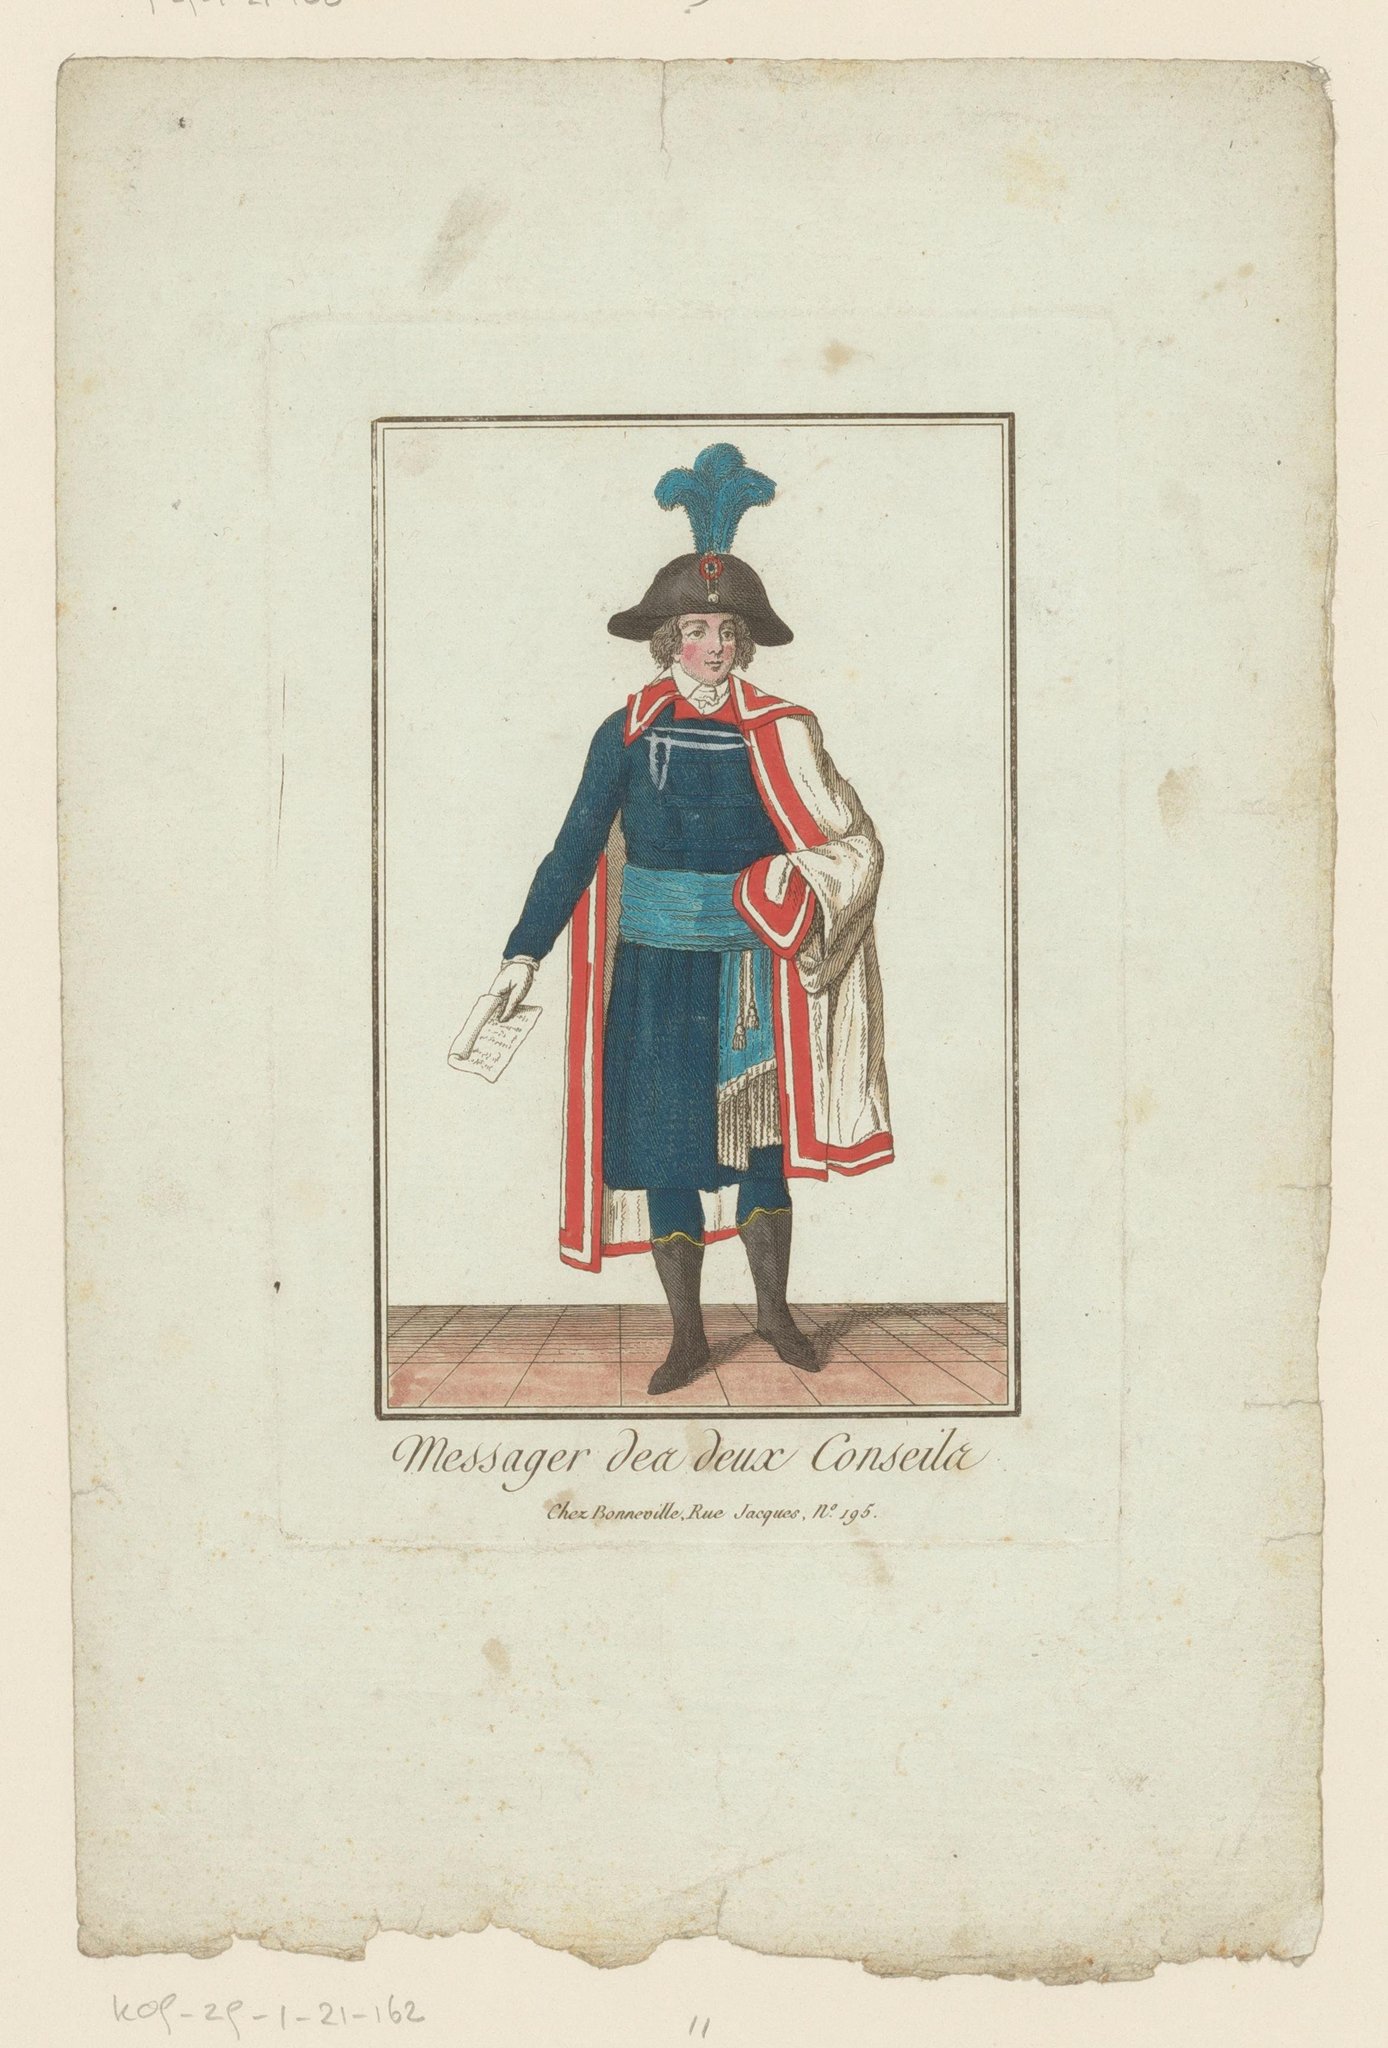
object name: print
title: Boodschapper van de twee raden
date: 1795-1799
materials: paper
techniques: etching, hand coloring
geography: paris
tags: standing figure, messenger, national government, clothes, costume, head-gear: hat (+ feathers used for clothes)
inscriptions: collector's mark: Lugt 1641, stamp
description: Onderwerpsrubrieken binnen de Atlas Zeden en Gewoonten: Zeden en Gewoonten in Engeren Zin, De Kleeding, Kleederdrachten (tijdvakken), De Fransche Revolutie. (Het Directoire).